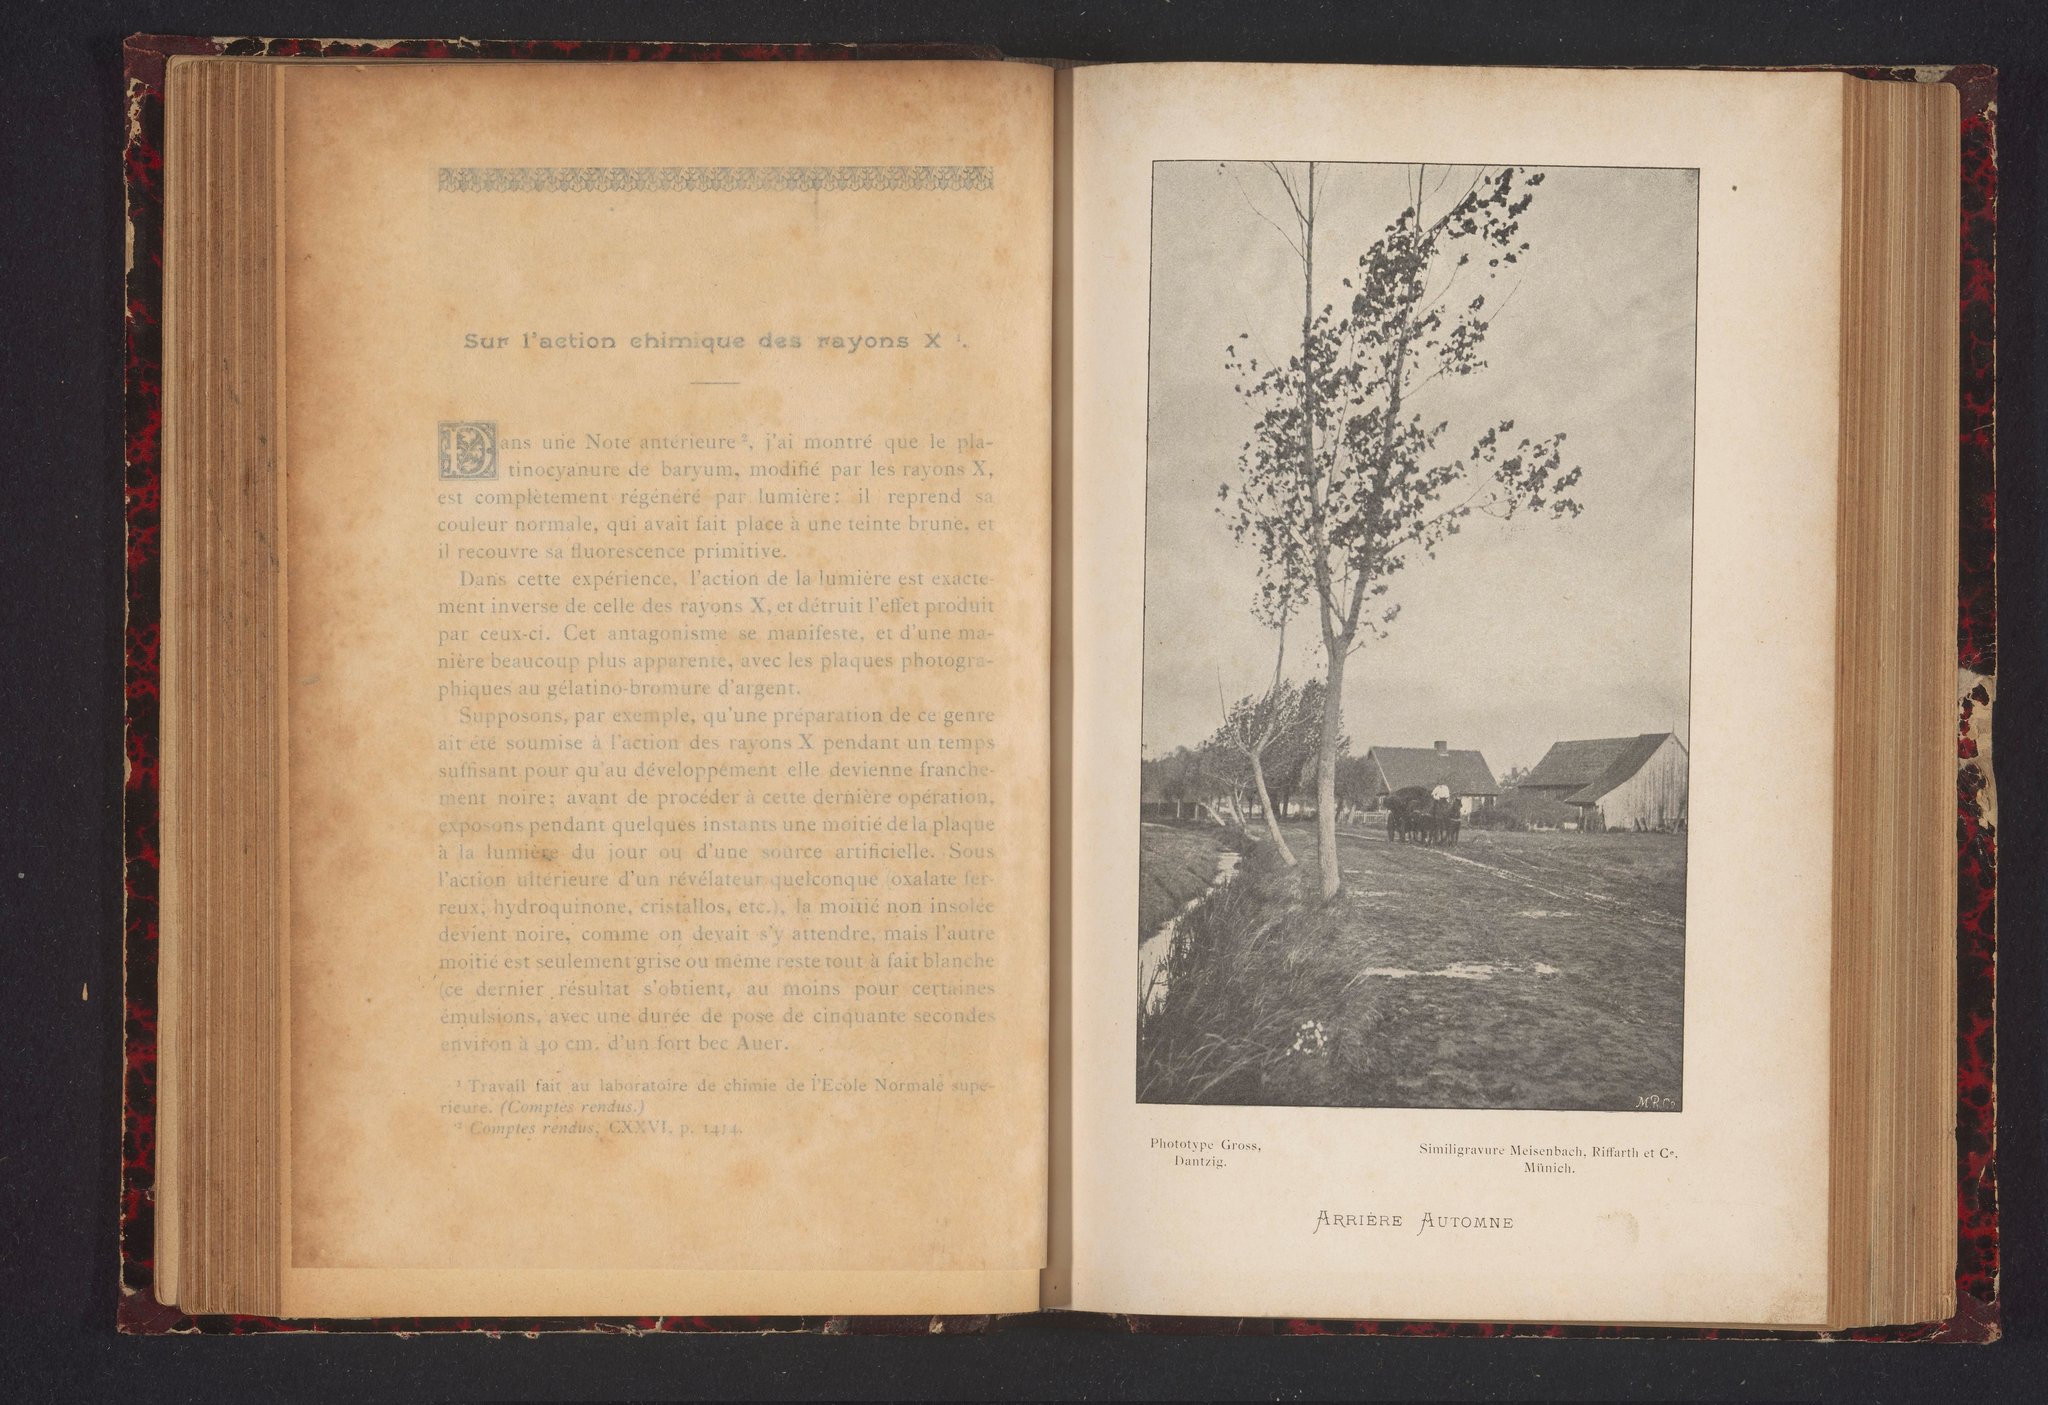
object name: photomechanical print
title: Arrière Automne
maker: gross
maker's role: fotograaf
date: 1894-1899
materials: paper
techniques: autotype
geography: munich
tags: four-wheeled vehicle drawn by two animals (+ one person ~ traffic and transport)